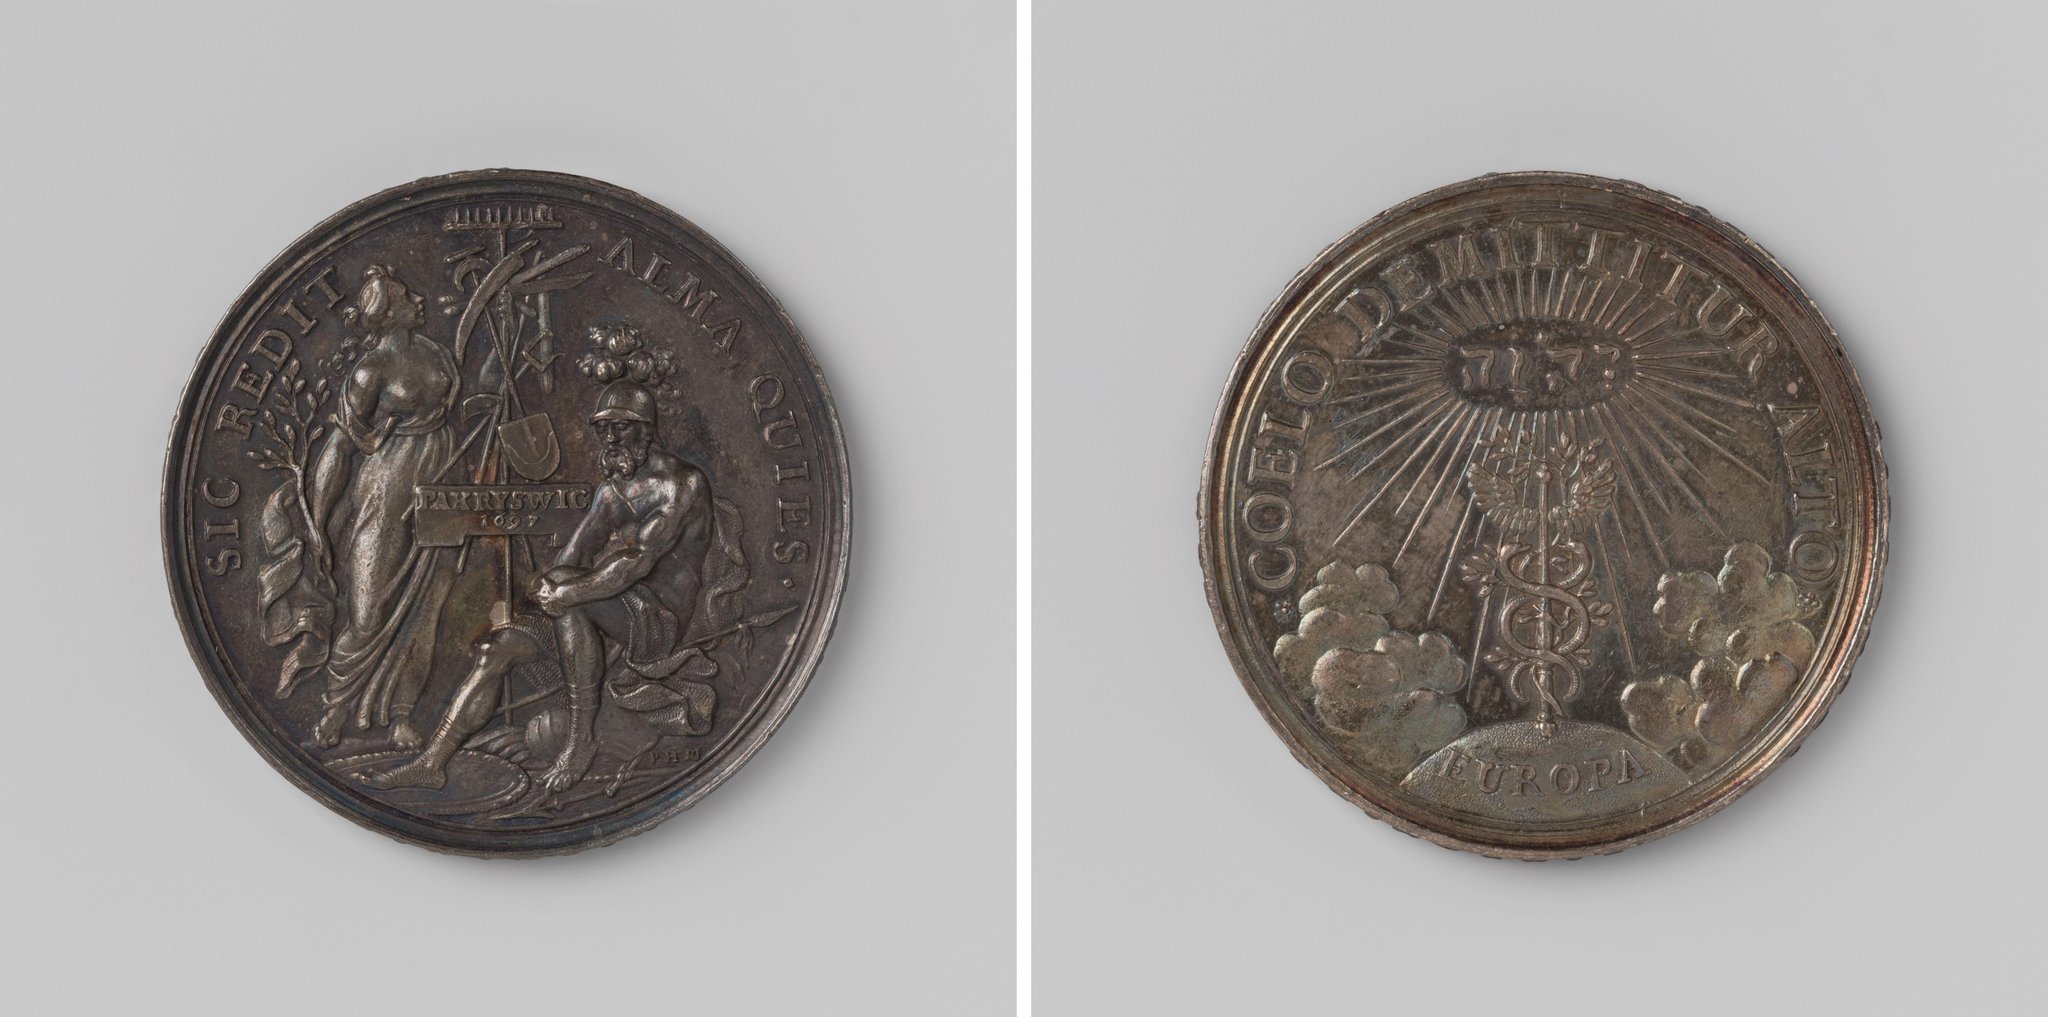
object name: history medal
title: Vrede van Rijswijk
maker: philipp heinrich müller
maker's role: medailleur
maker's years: 1654-1719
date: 1697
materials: silver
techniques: striking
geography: nuremberg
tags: rijswijk, vrede van rijswijk (1697)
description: Zilveren penning. Voorzijde: vermoeide Mars zittend op stapel wapentuig, terwijl Vrede ereteken van landbouwgereedschappen omhoog houdt binnen omschrift. Keerzijde: met olijftakken omvlochten Mercuriusstaf, geplant op wereldbol met opschrift Europa en beschenen door hemellicht binnen omschrift; randschrift